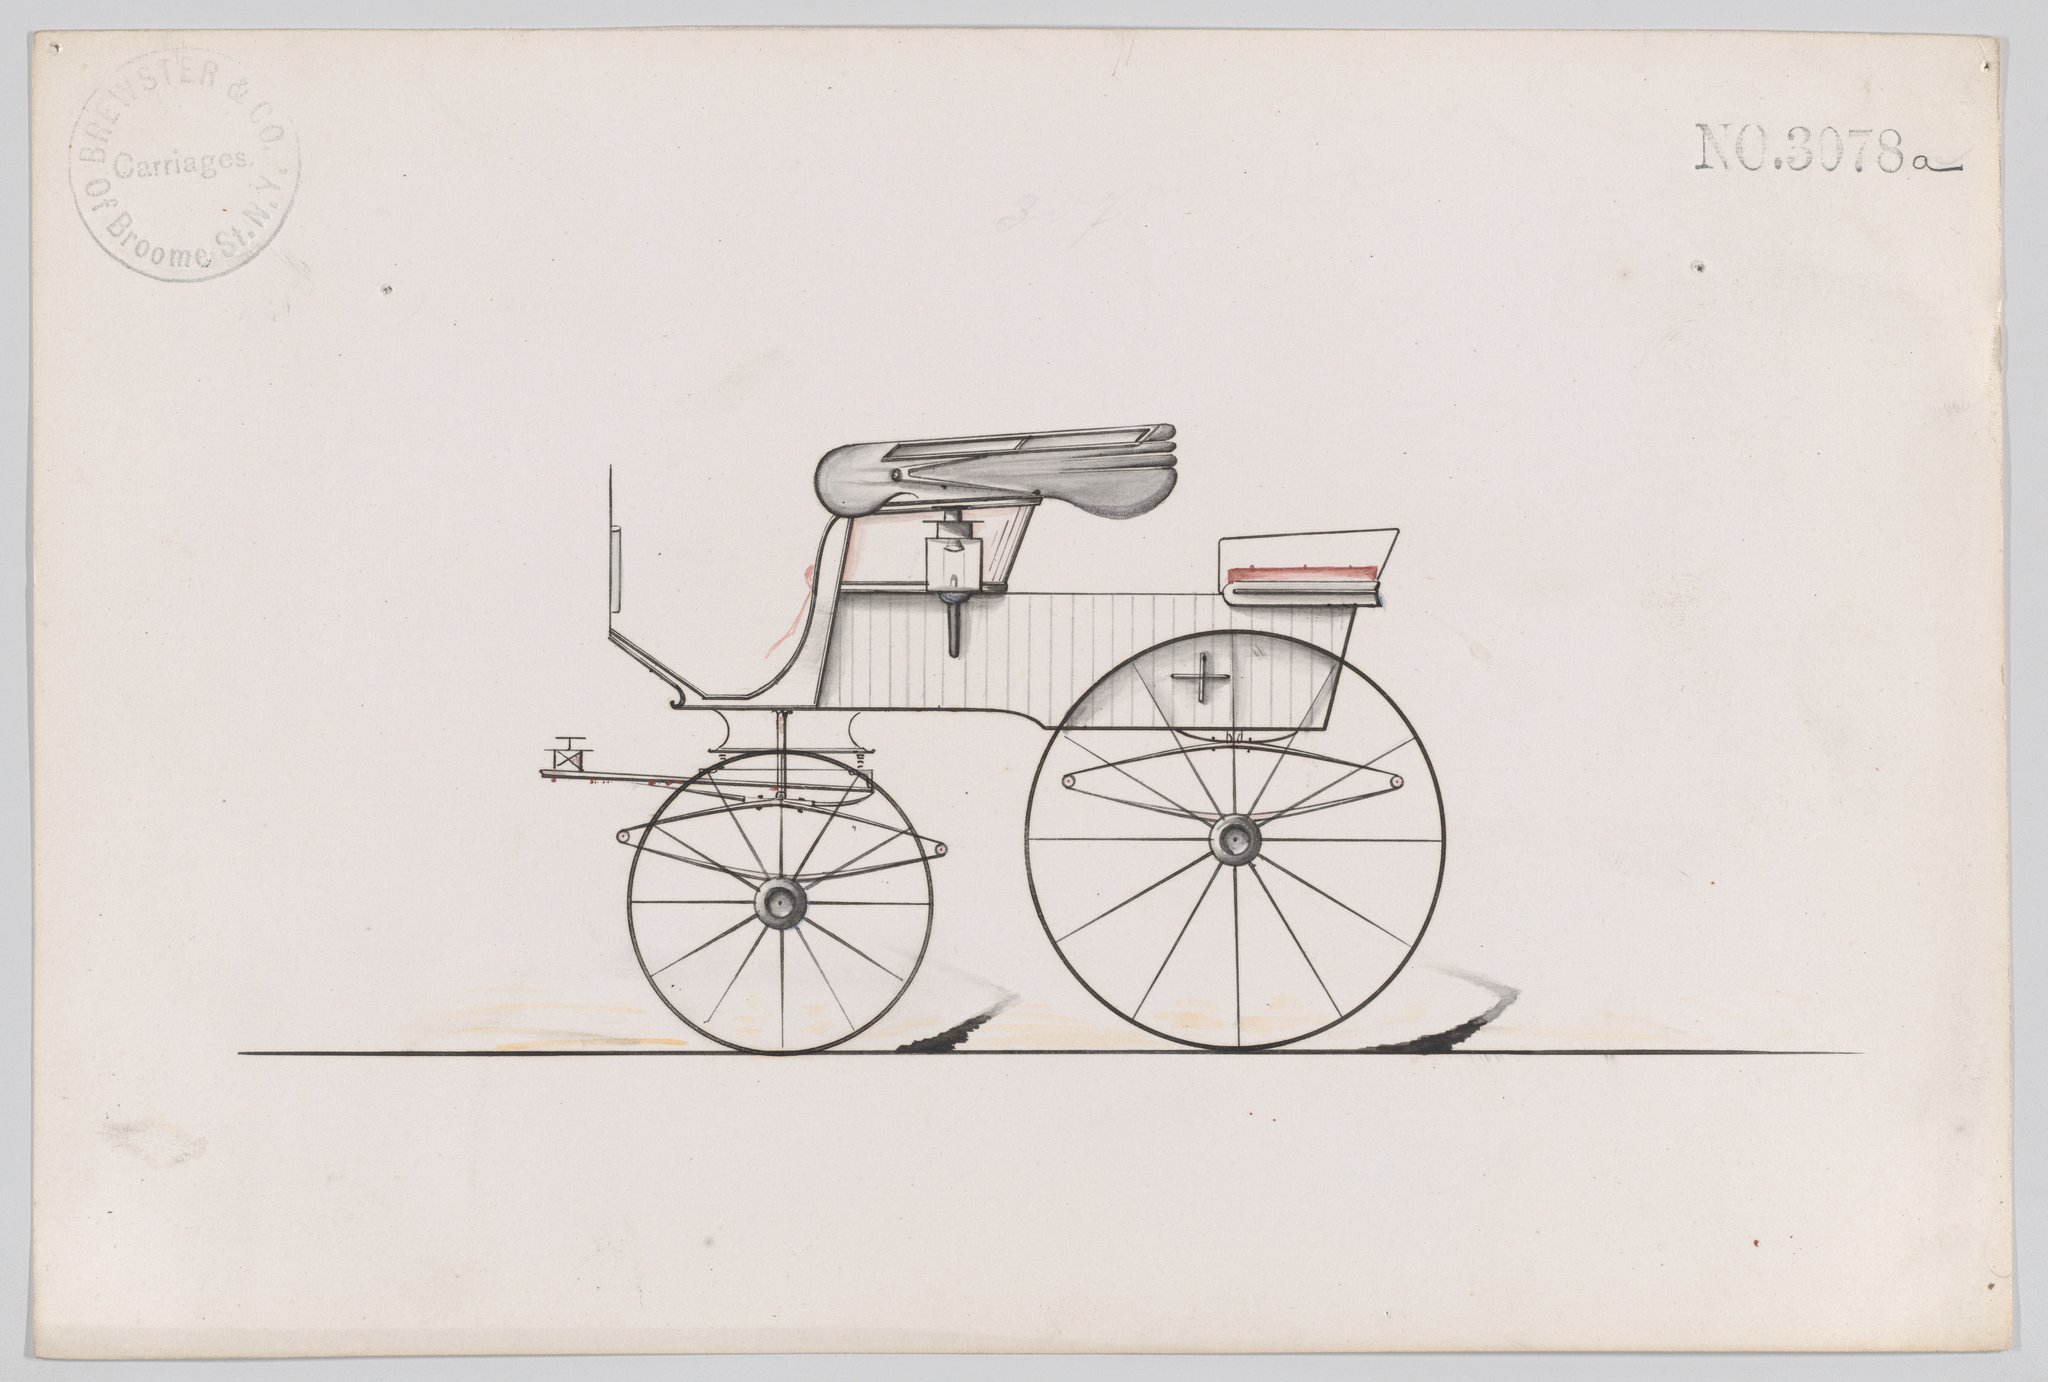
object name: drawing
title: Design for Stanhope Phaeton, no. 3078a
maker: brewster & co.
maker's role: manufacturer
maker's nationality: american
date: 1874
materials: gouache, ink, watercolor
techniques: pen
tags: carriages